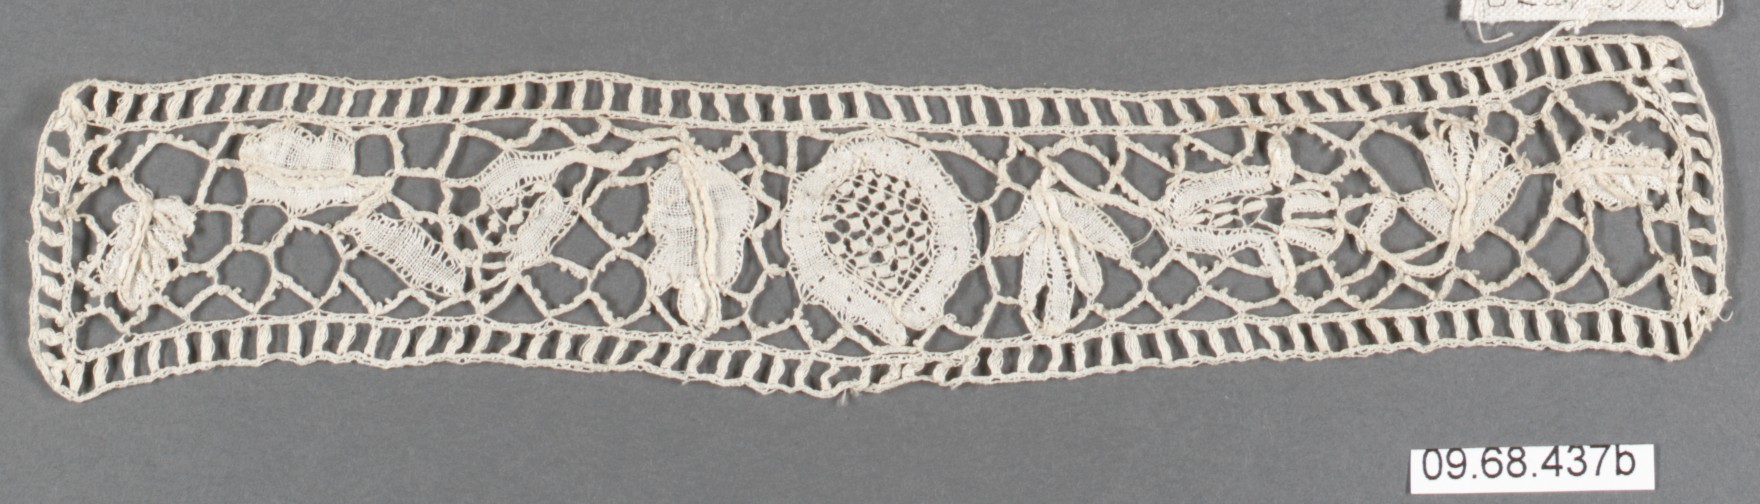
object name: cuff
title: Cuff (one of a pair)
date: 1801-1900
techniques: lace